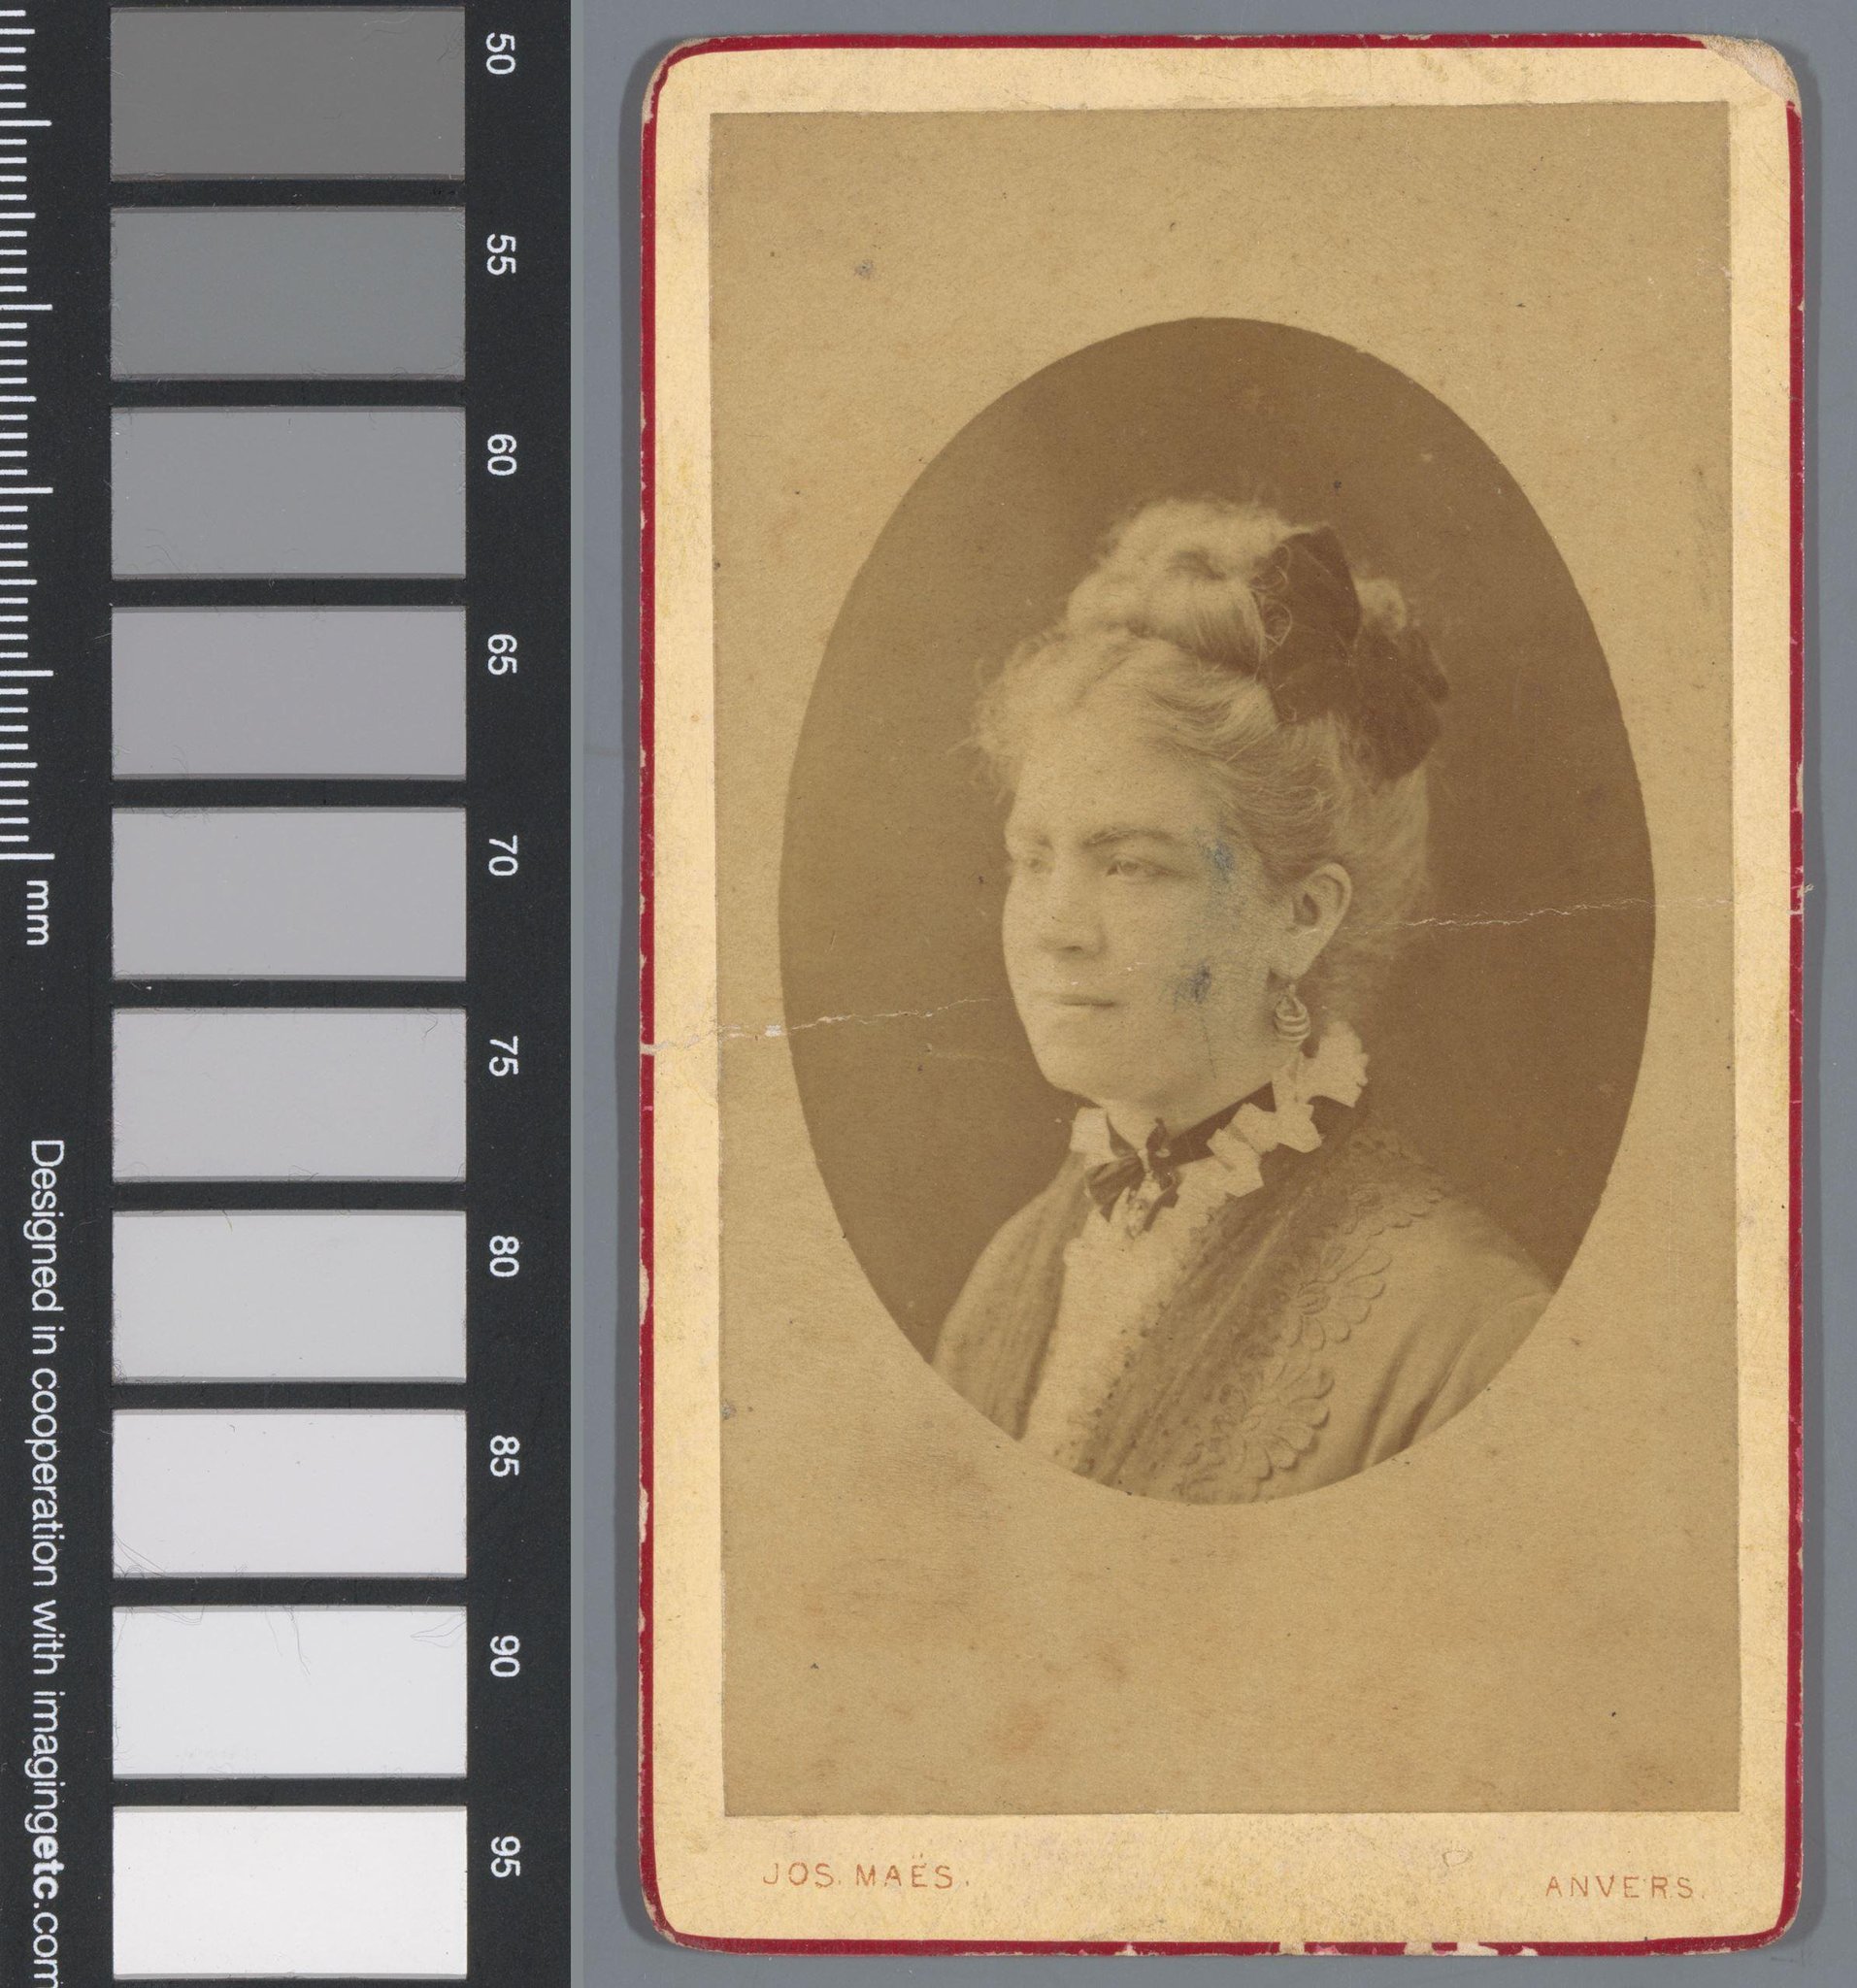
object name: photograph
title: Portret van een onbekende vrouw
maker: joseph maes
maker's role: fotograaf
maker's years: 1838-1908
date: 1875-1882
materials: cardboard, paper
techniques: albumen print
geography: antwerp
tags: historical persons - bb - woman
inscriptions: inscription: ‘PHOTOGRAPHIE/ INALTÉRABLE/ JOS MAES/ 23/ REMPART/ Ste./ CATHERINE/ ANVERS’